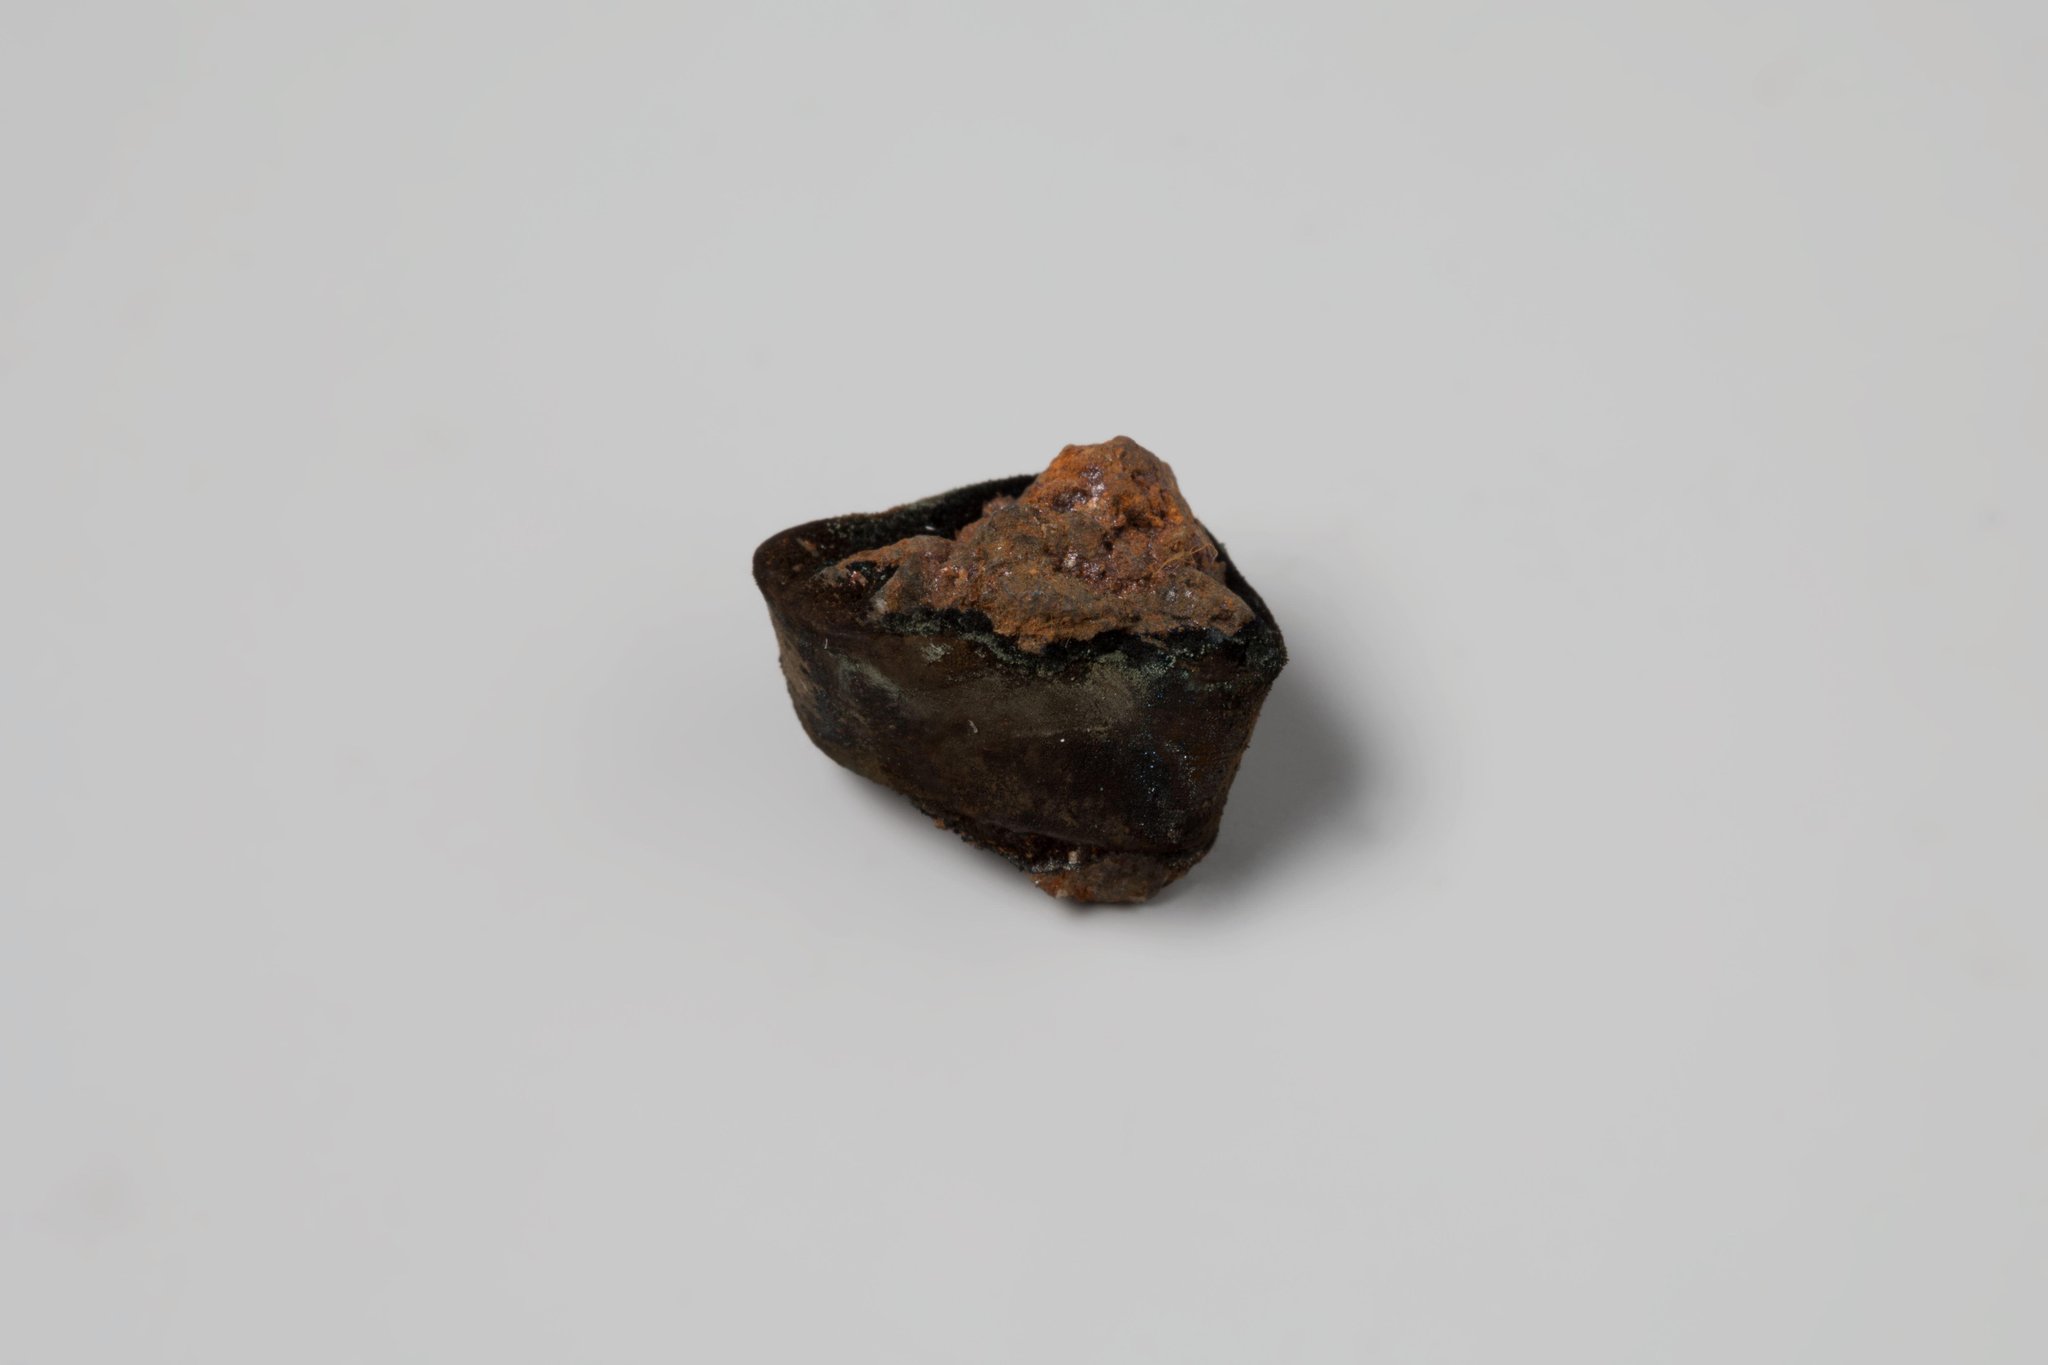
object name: ferrule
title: Messenheftring uit het wrak van de Oost-Indiëvaarder Hollandia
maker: Anonymous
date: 1700-1743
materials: copper, wood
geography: netherlands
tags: verenigde oostindische compagnie, hollandia (schip), annet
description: Knife-handle, ferrule; id. NG 1980-27H426.